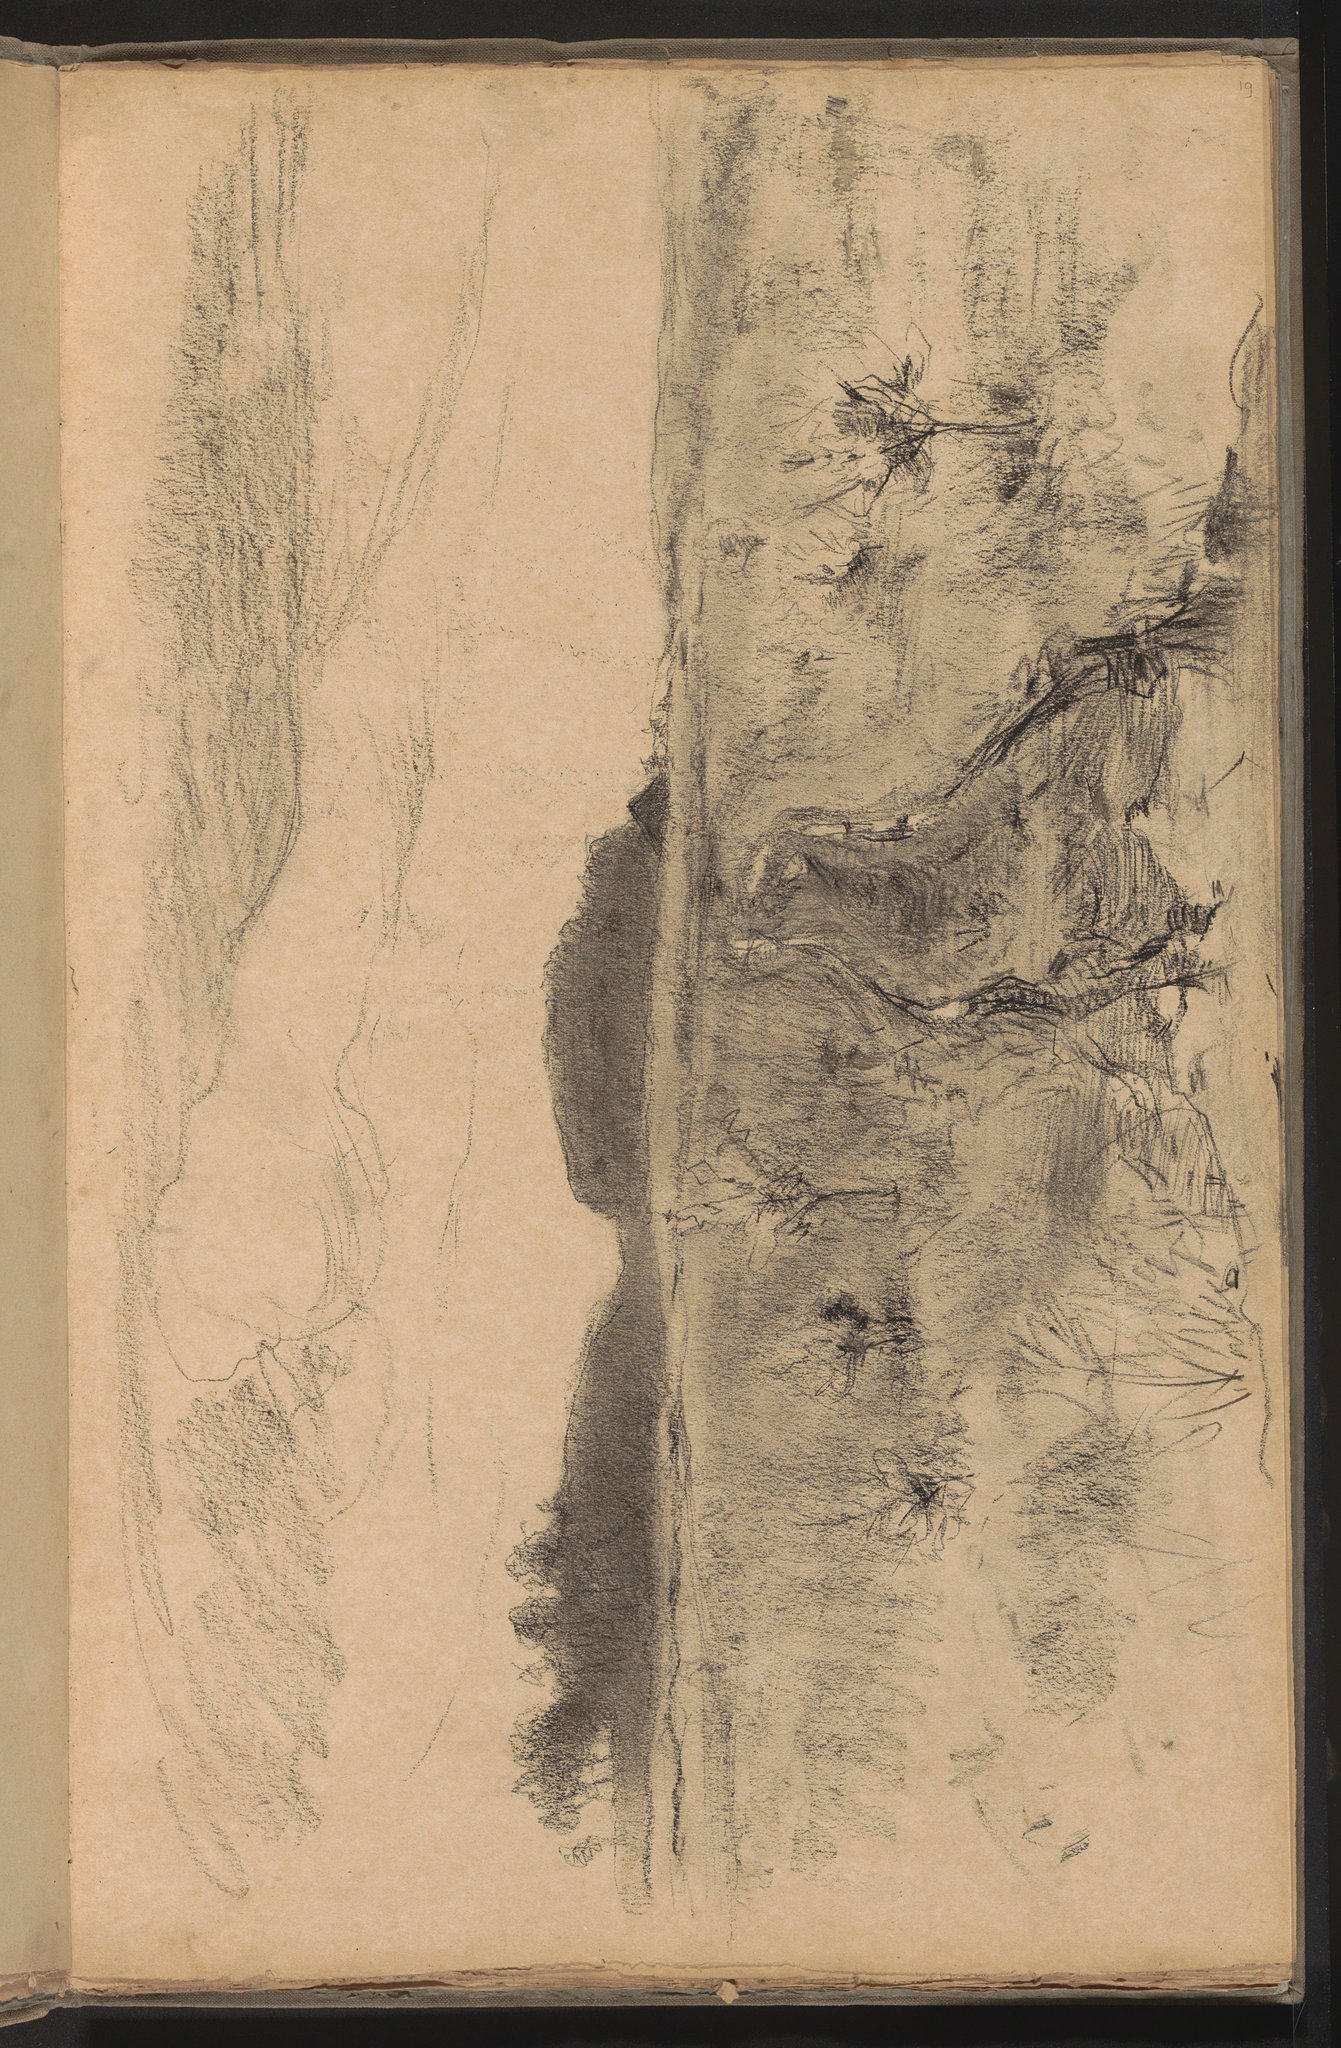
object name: sketchbook leaf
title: Landschap met bebouwing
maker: willem witsen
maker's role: draughtsman, painter, print maker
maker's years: 1860-1923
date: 1884-1887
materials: chalk, paper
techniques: stumping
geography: ewijkshoeve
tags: water course, farm or solitary house in landscape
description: In het midden een pad of rivier. Pagina 19 uit een schetsboek met 38 bladen.